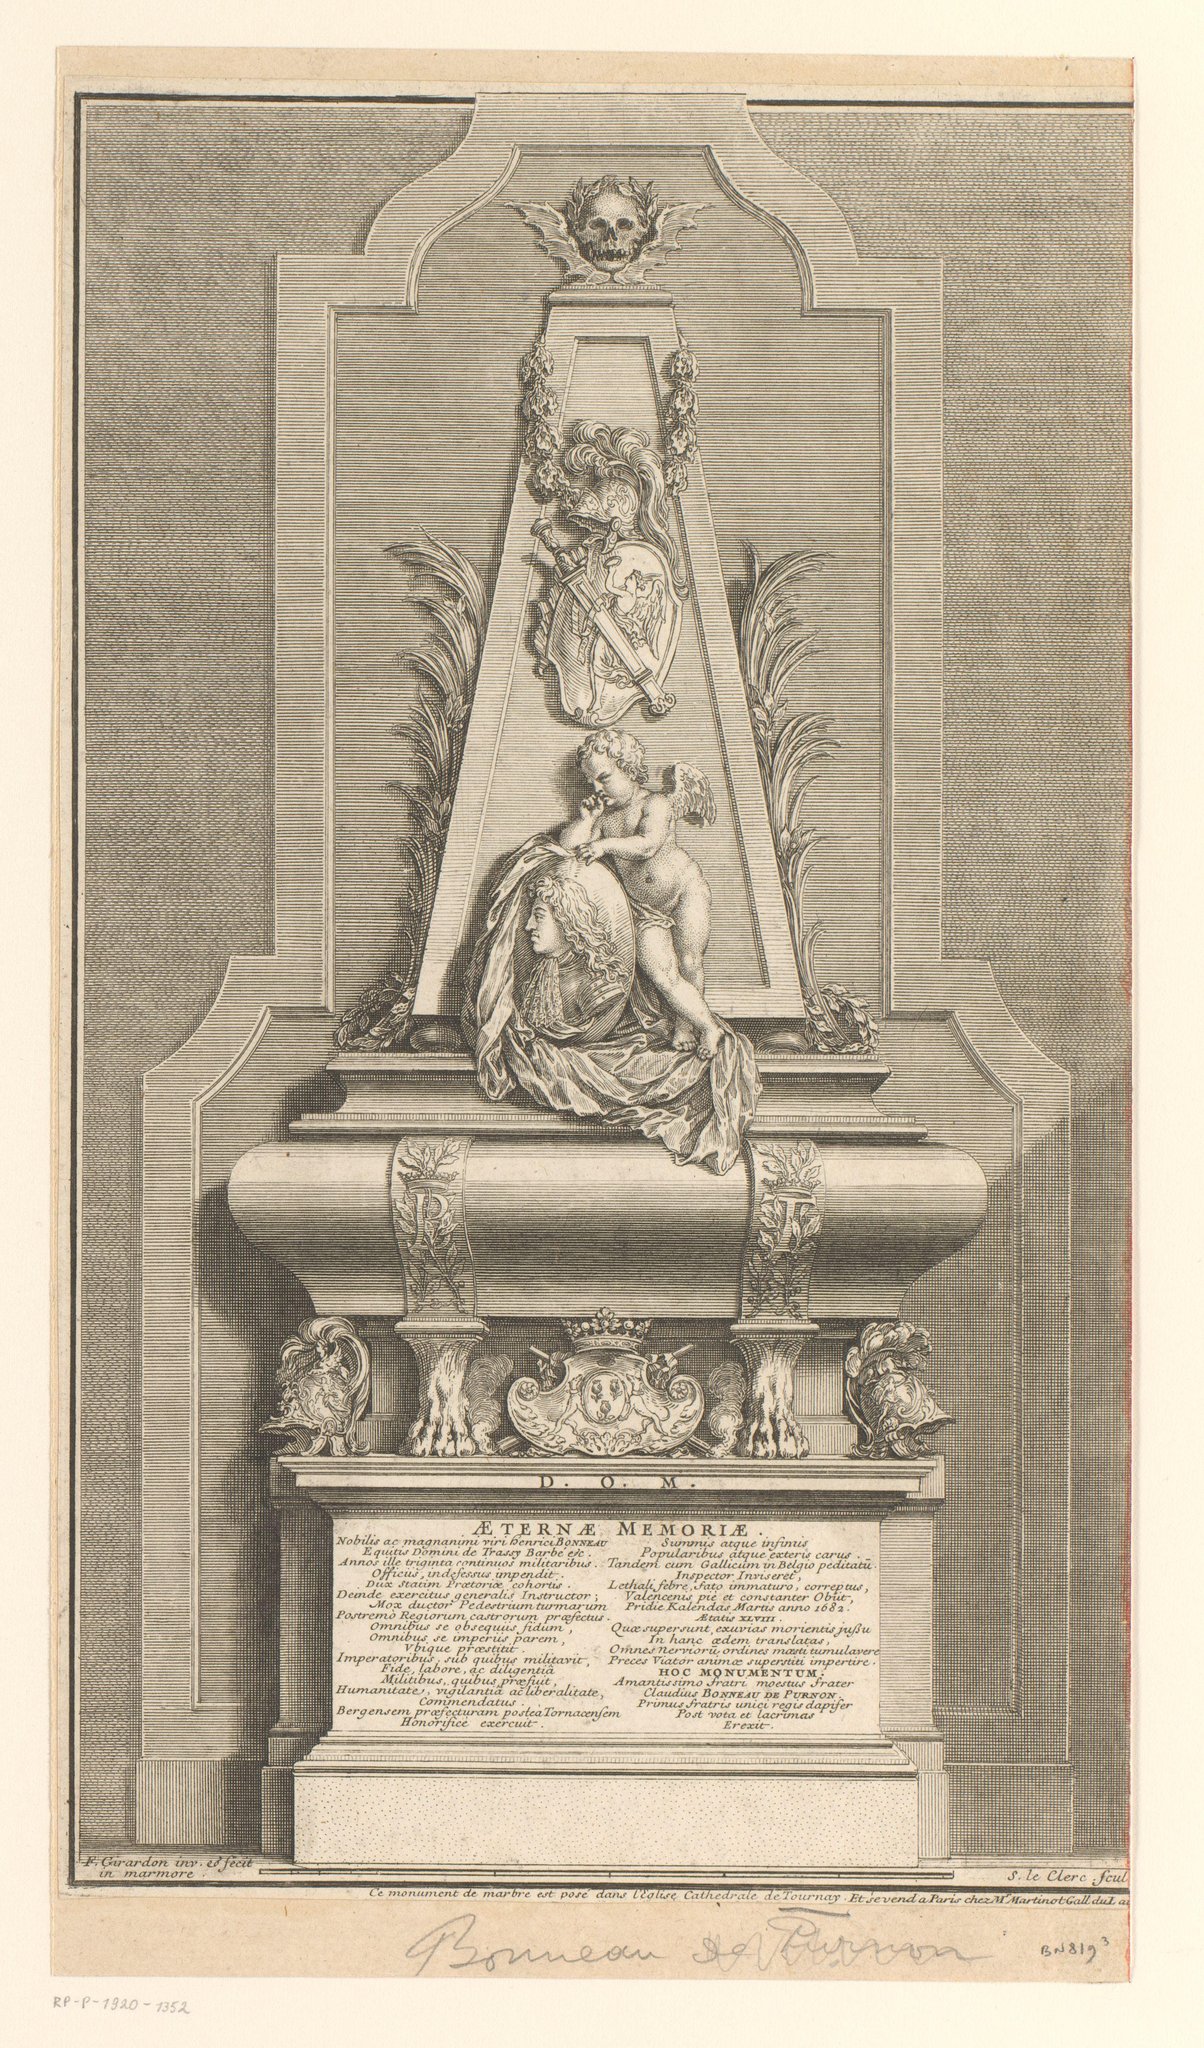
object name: print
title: Graftombe van Henri Bonneau de Trassy in de kathedraal van Doornik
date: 1647-1714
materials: paper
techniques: engraving, etching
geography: paris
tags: grave, tomb, armorial bearing, heraldry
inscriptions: collector's mark: Lugt 2228